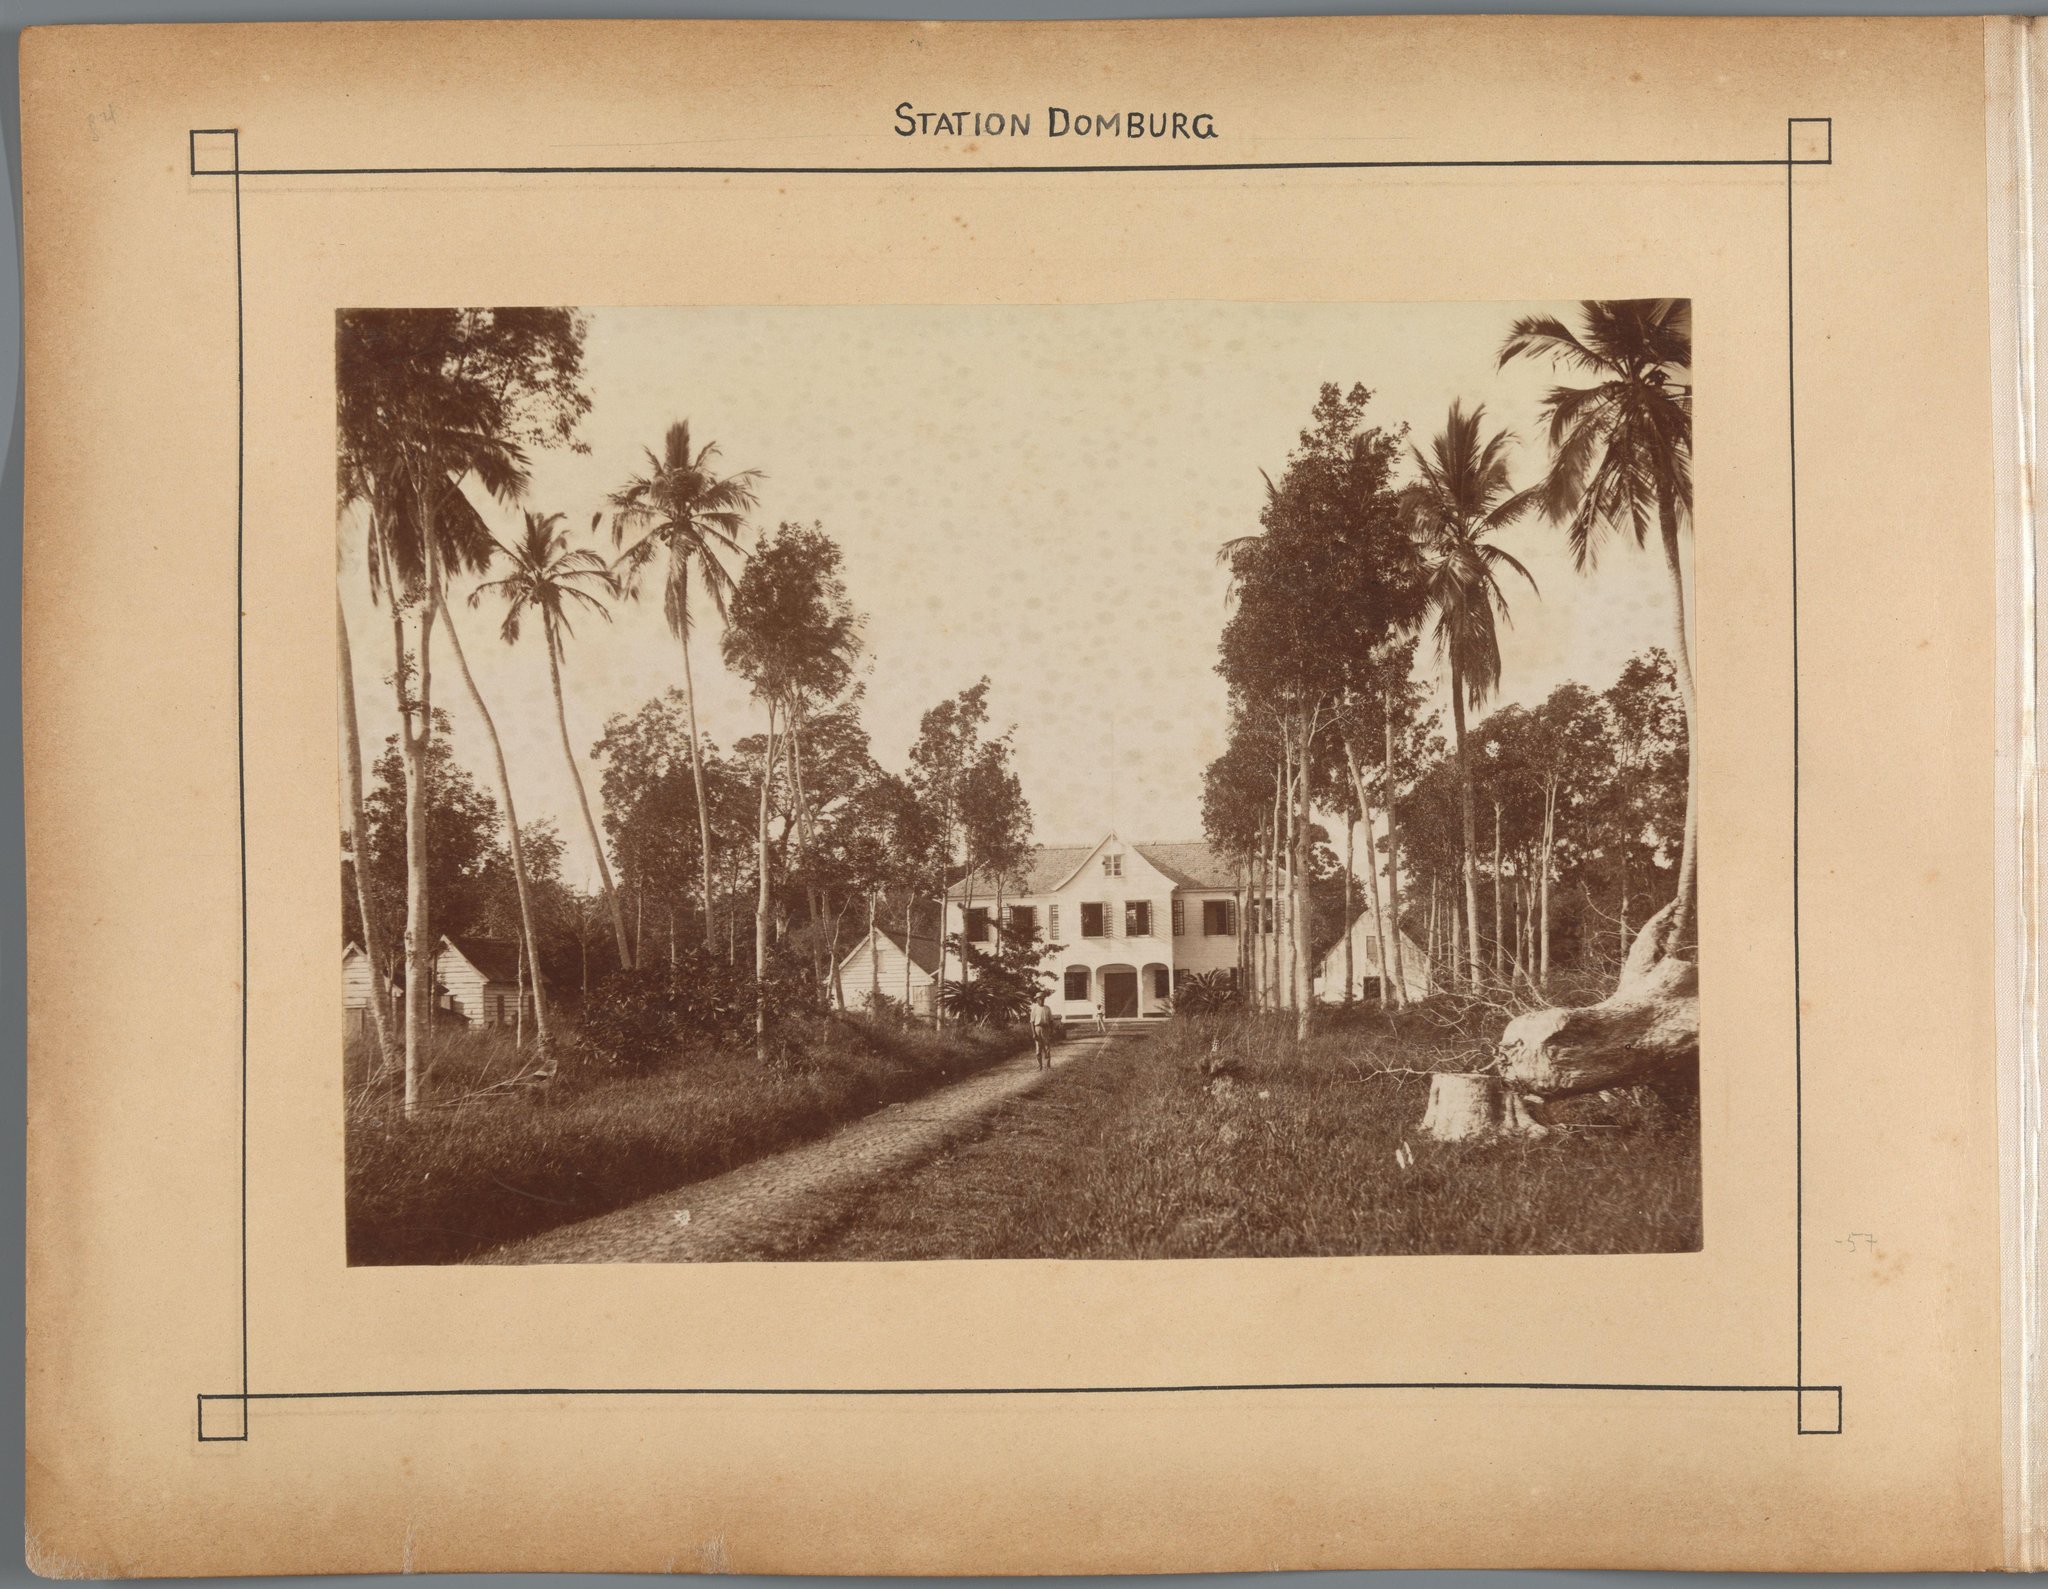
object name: photograph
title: Station Domburg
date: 1898-1902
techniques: albumen print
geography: suriname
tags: suriname